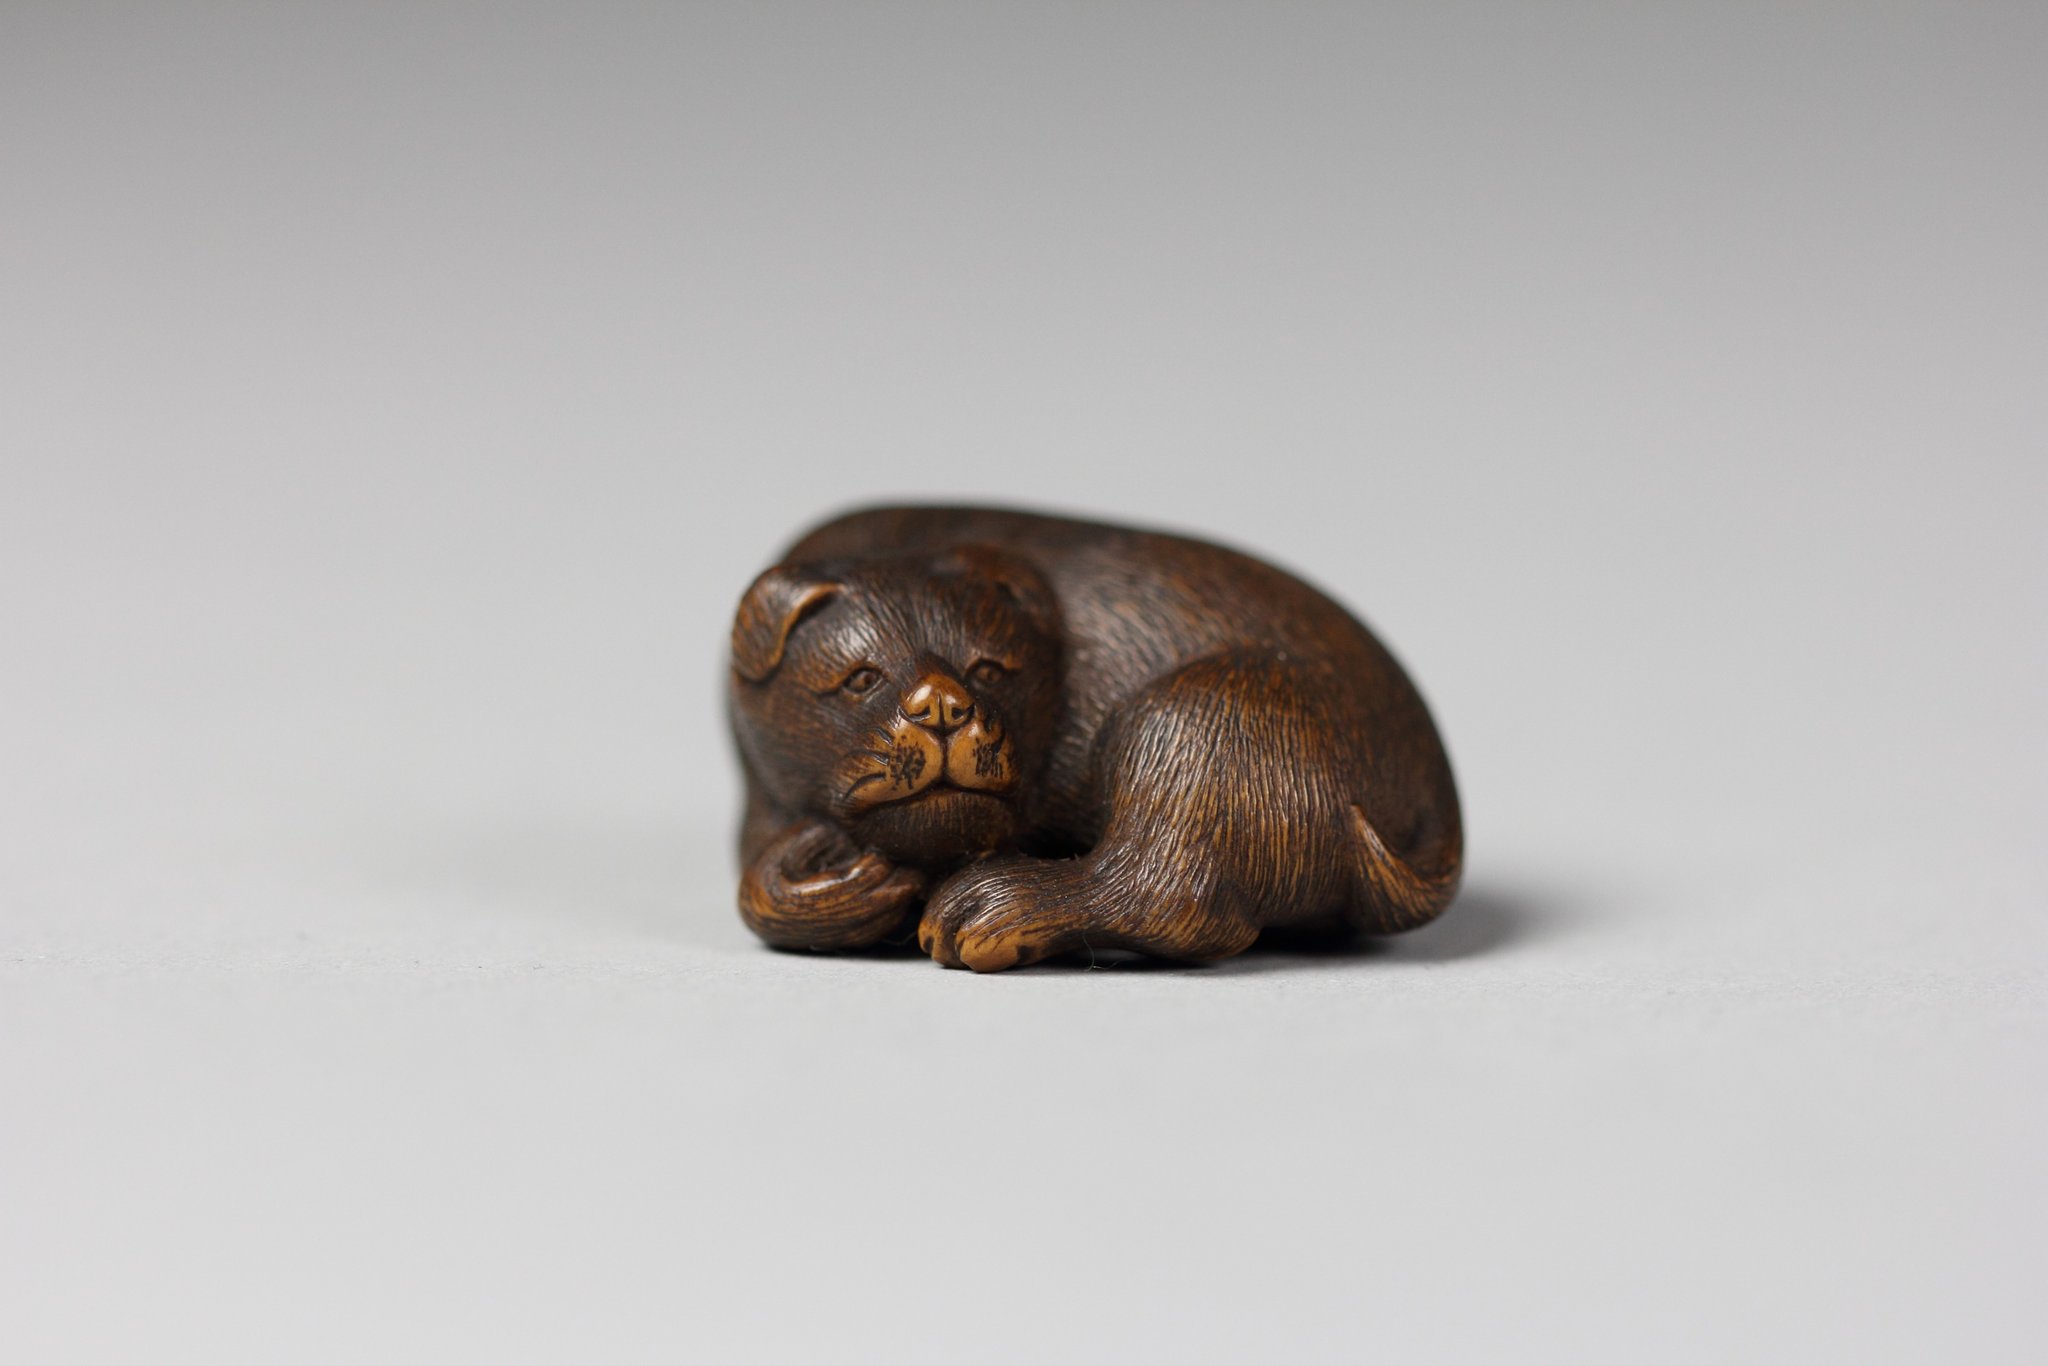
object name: netsuke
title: Netsuke of a Dog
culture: japanese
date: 1801-1900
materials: wood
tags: dogs